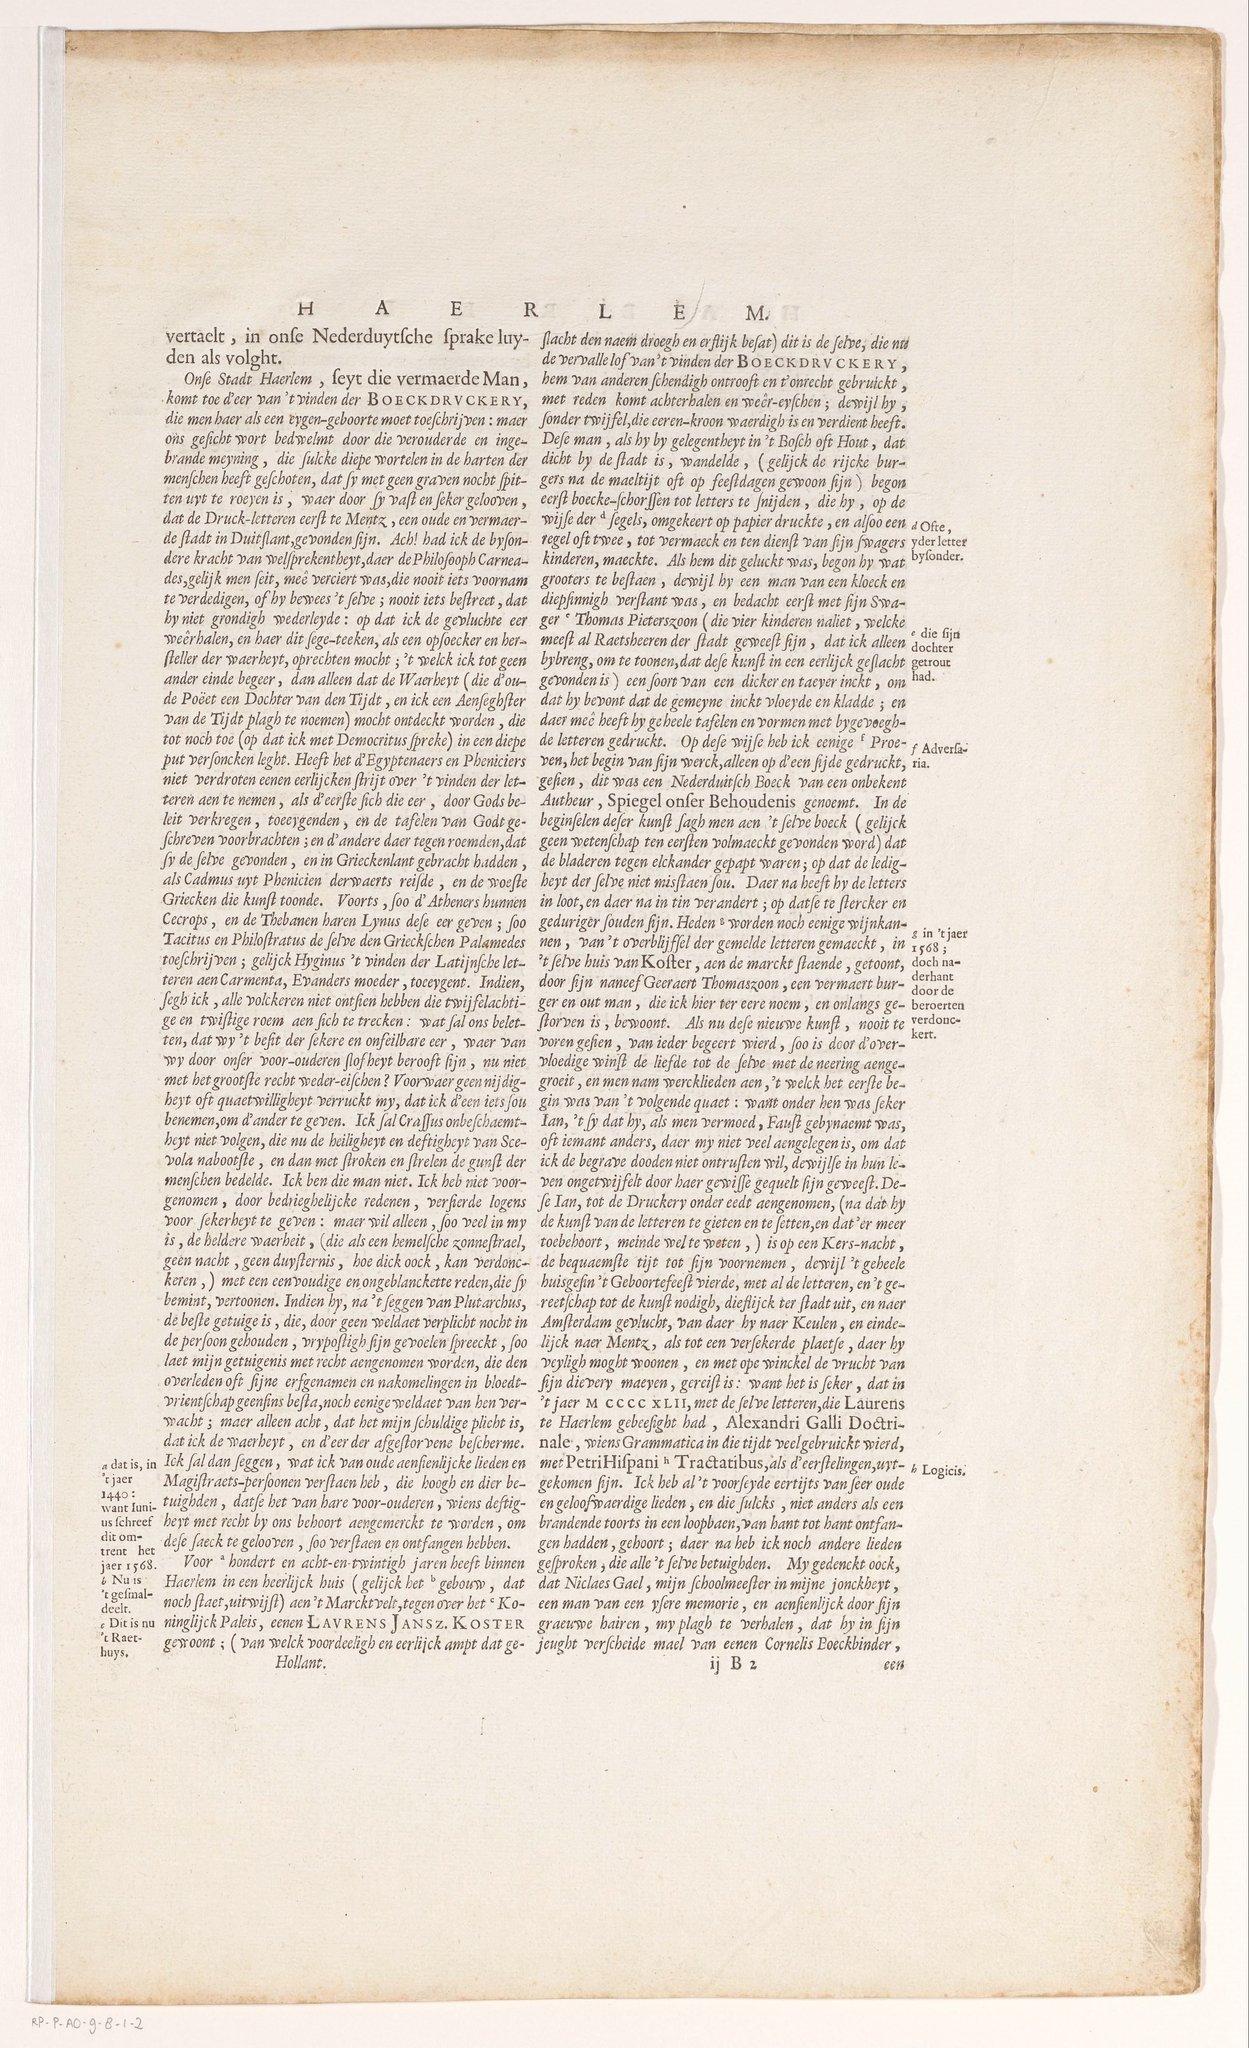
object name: text sheet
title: Deel van een beschrijving van de stad Haarlem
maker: johannes willemszoon blaeu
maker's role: printer, publisher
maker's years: 1596-1673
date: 1652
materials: paper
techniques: letterpress printing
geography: amsterdam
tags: haarlem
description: Tekst gebruikt in: Blaeu, Johannes Willemszoon. Toonneel der steden van de Vereenighde Nederlanden. 2 delen. Amsterdam: Johannes Willemszoon Blaeu, 1652, dl. 1. Zie ook RP-P-AO-9-8-1-1.